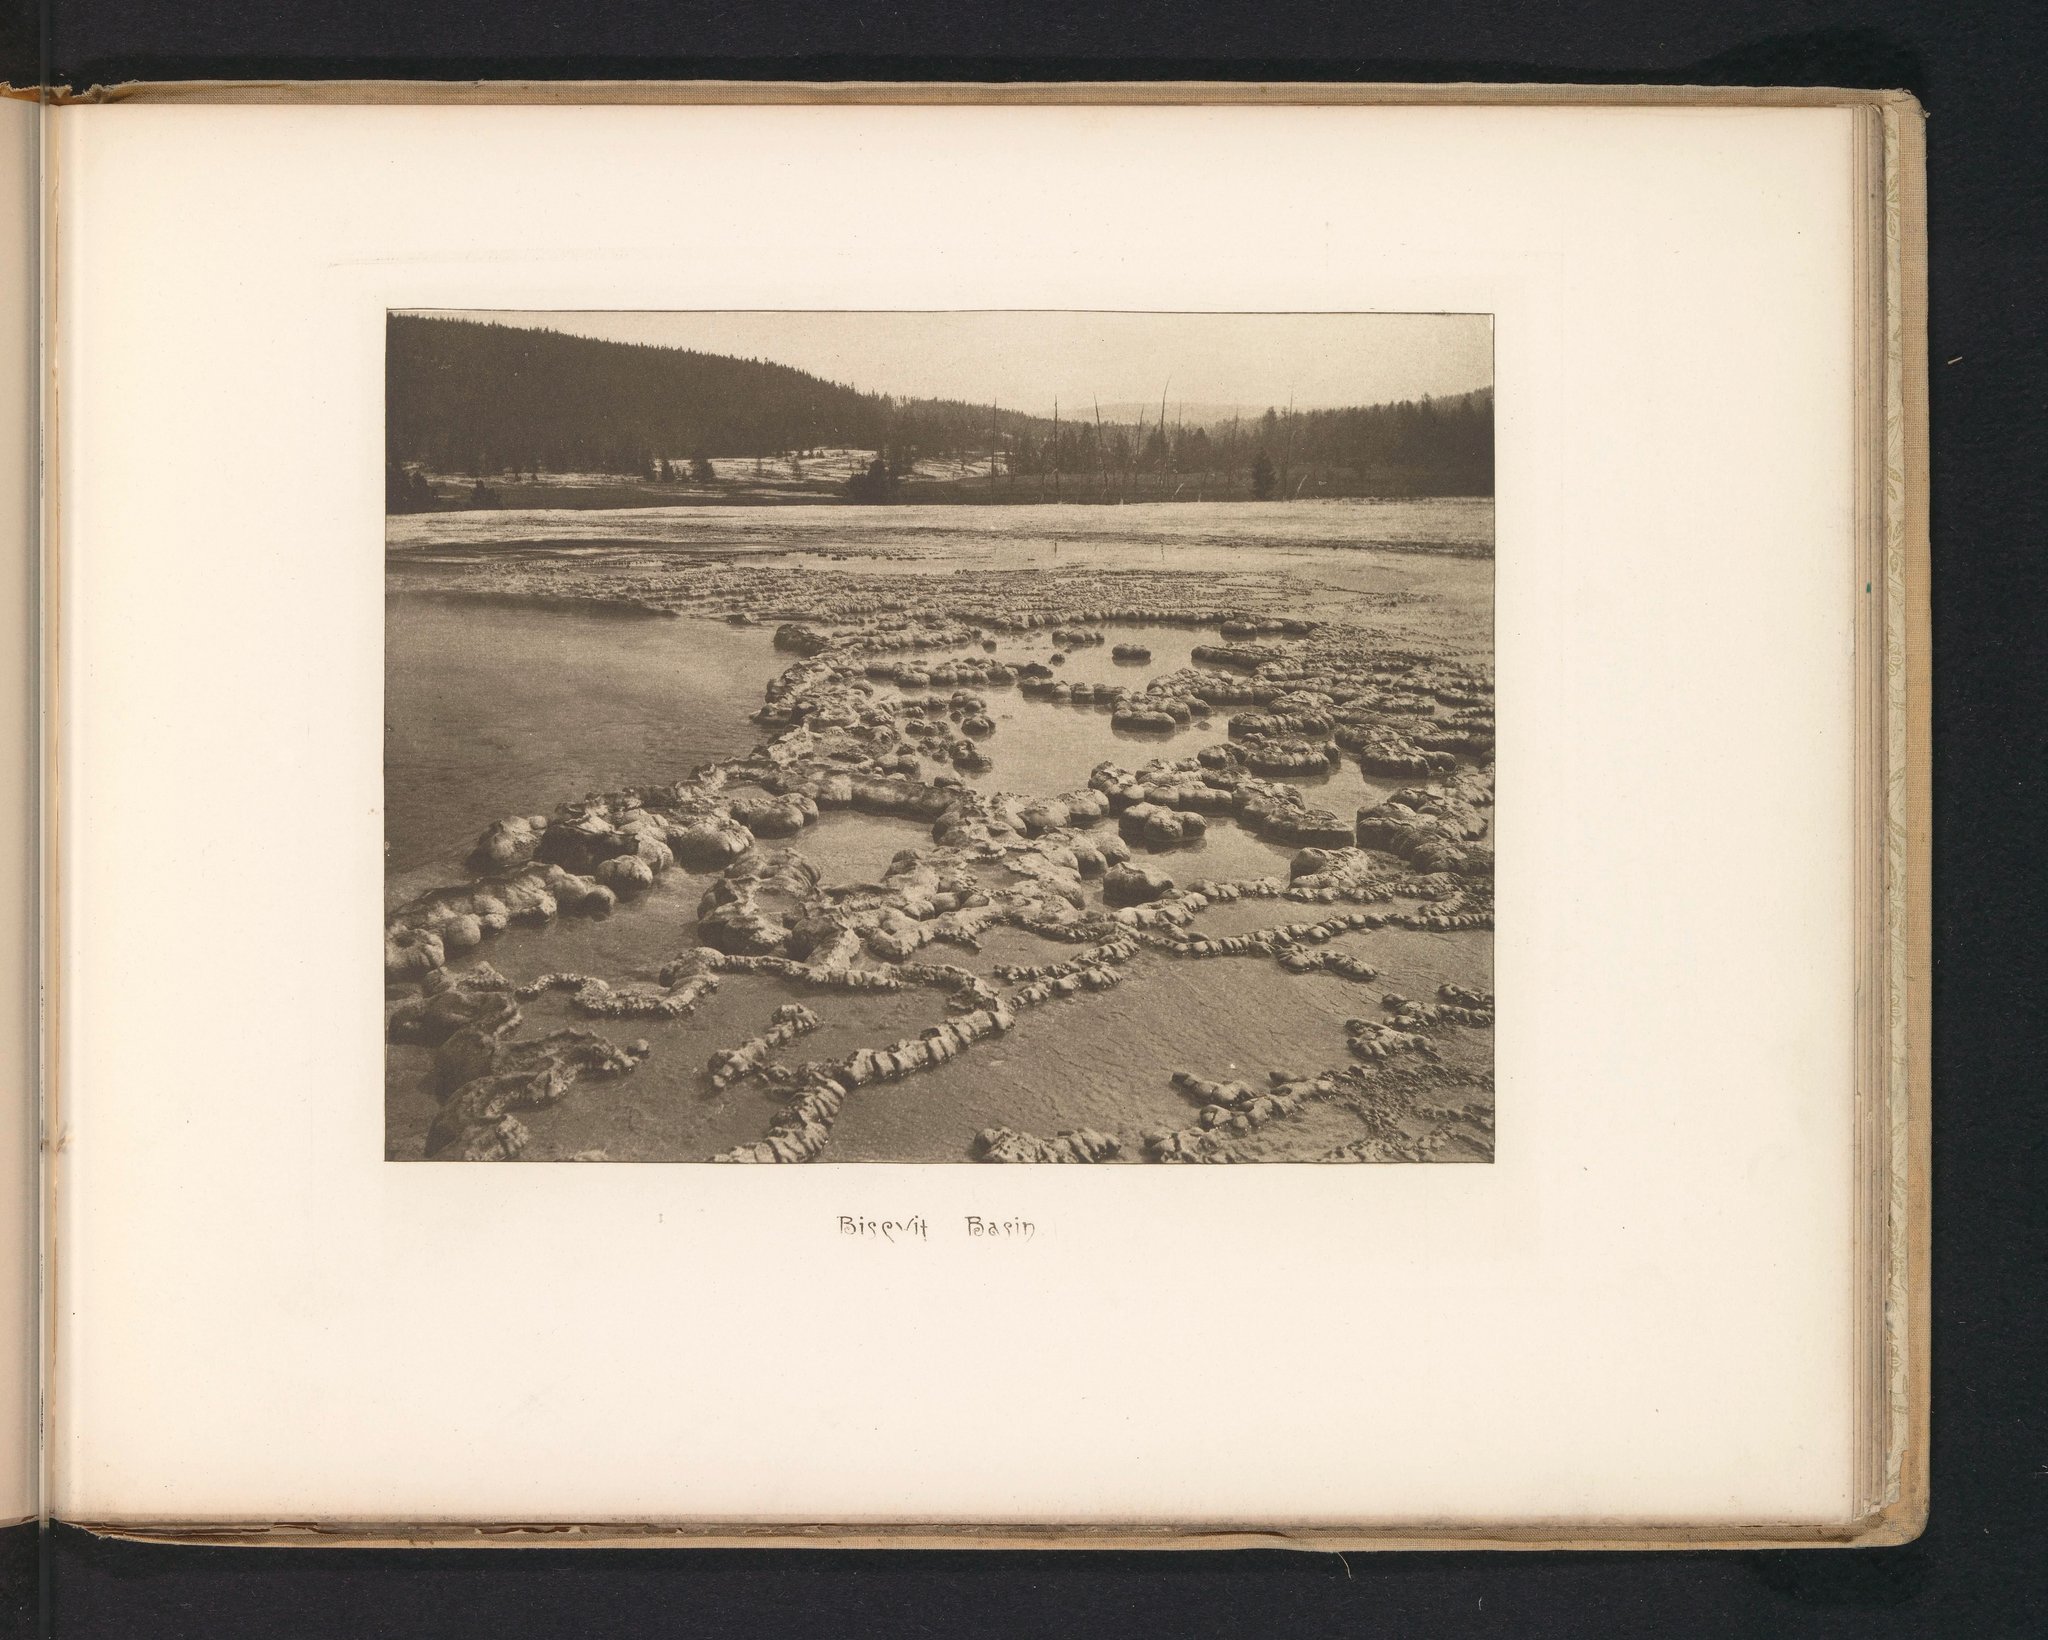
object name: photomechanical print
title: Biscuit Basin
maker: frank jay haynes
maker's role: fotograaf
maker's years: 1853-1921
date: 1882-1887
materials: paper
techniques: photoaquatint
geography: yellowstone national park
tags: pond, pool